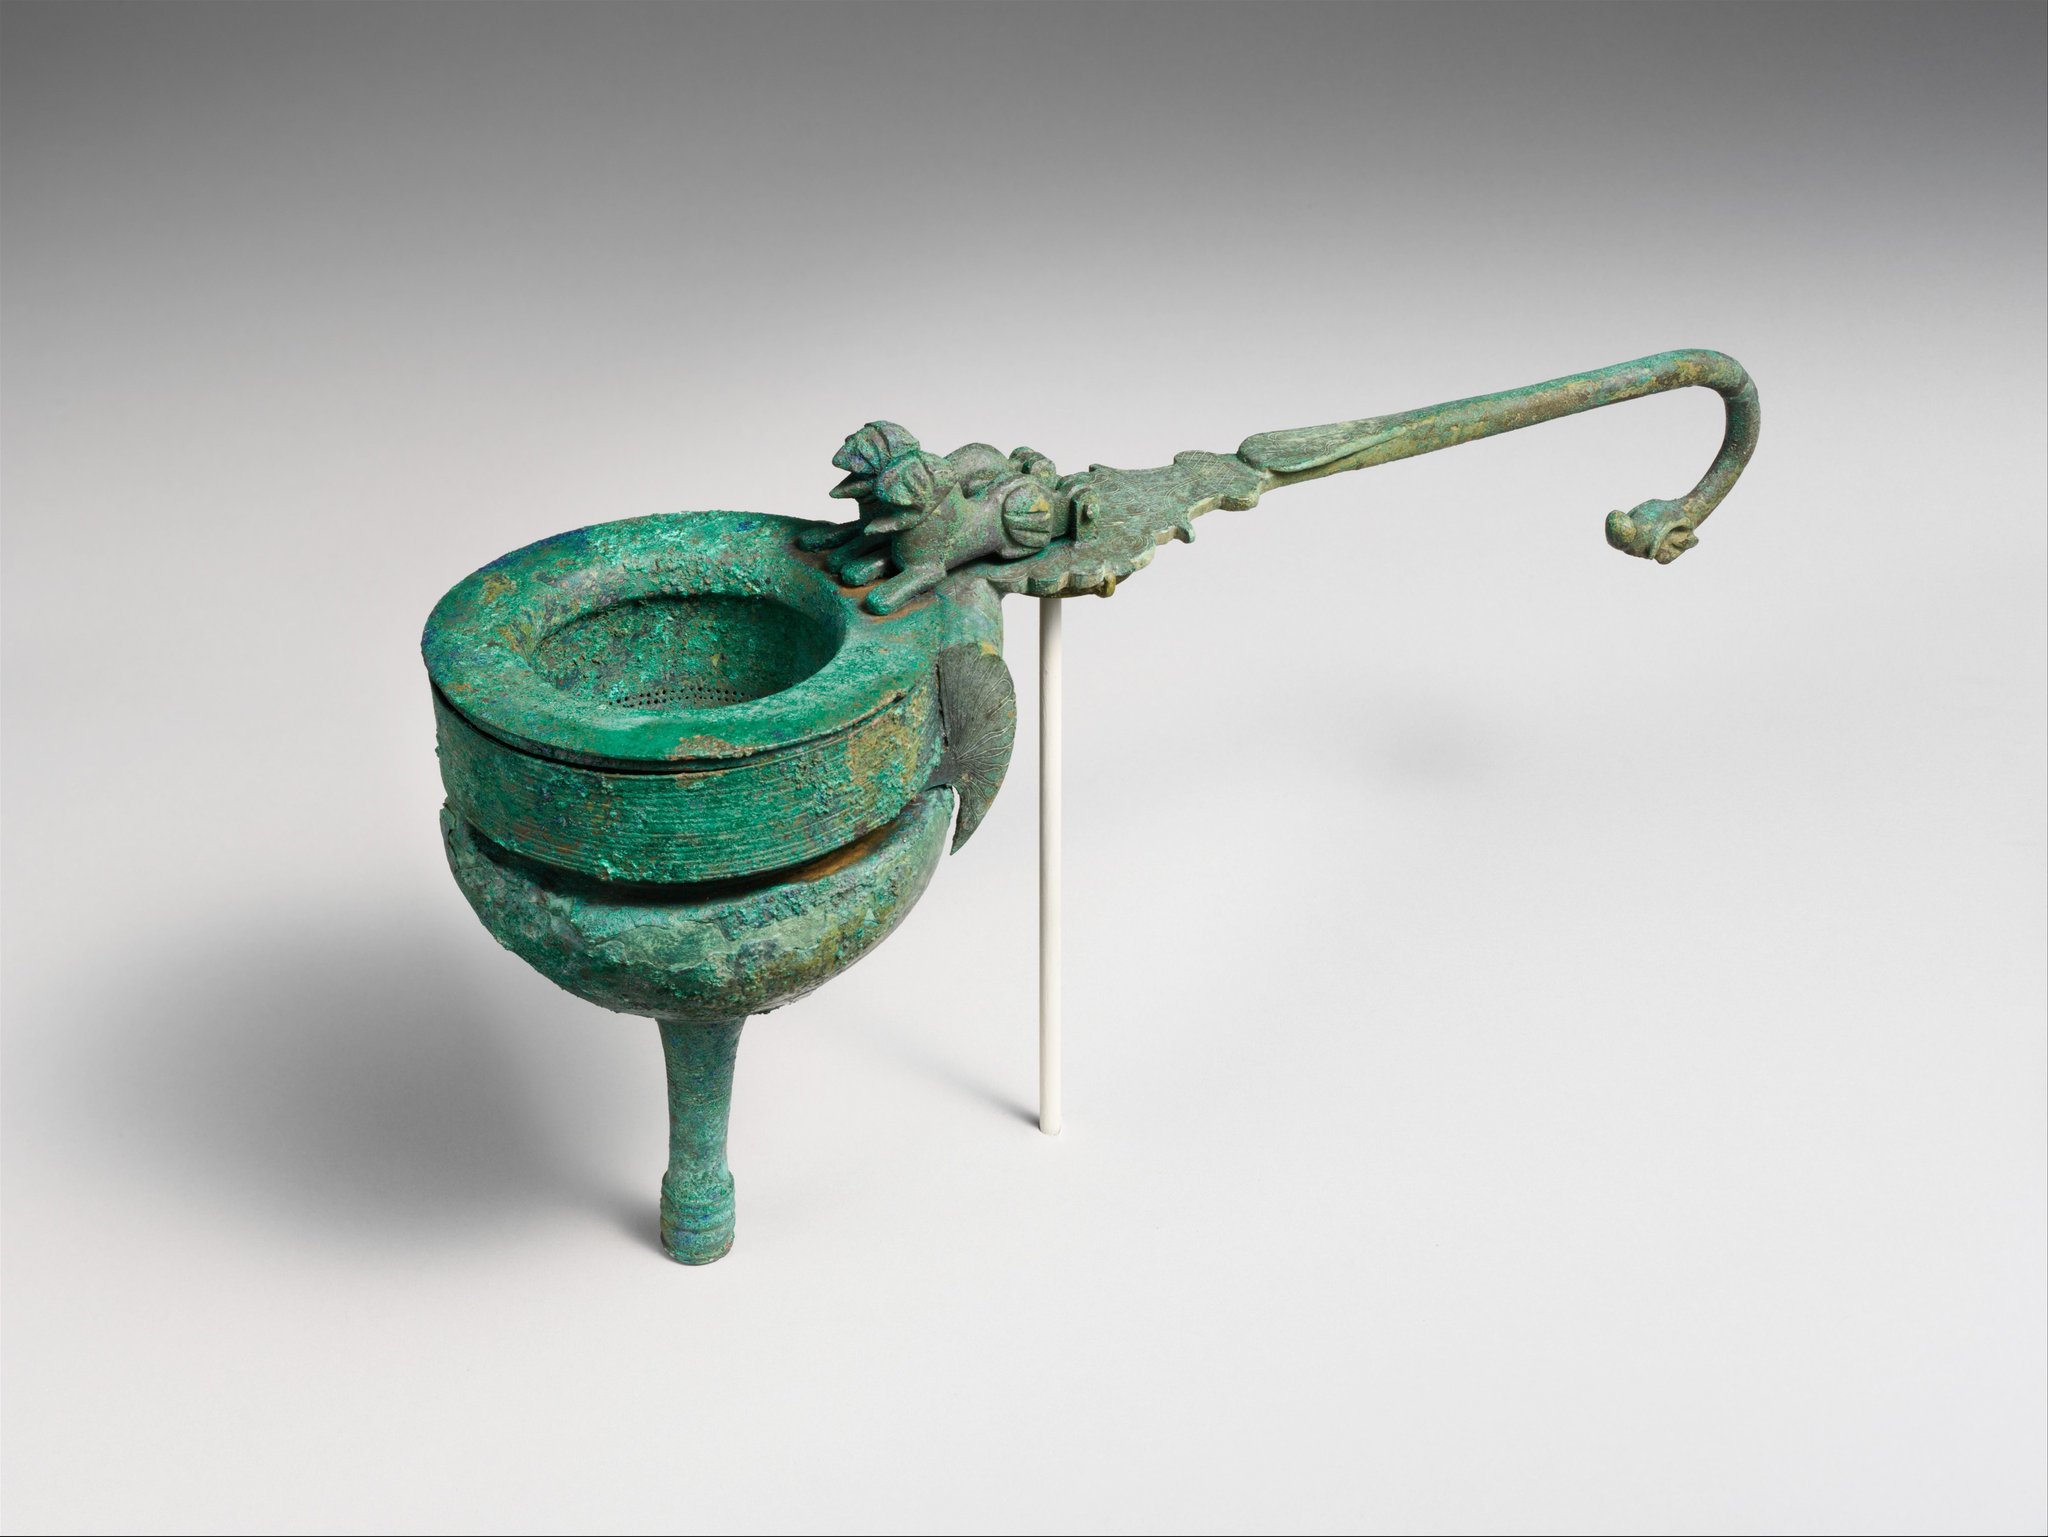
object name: strainer with funnel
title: Bronze funnel-strainer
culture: etruscan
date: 550-500 BCE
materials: bronze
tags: lions